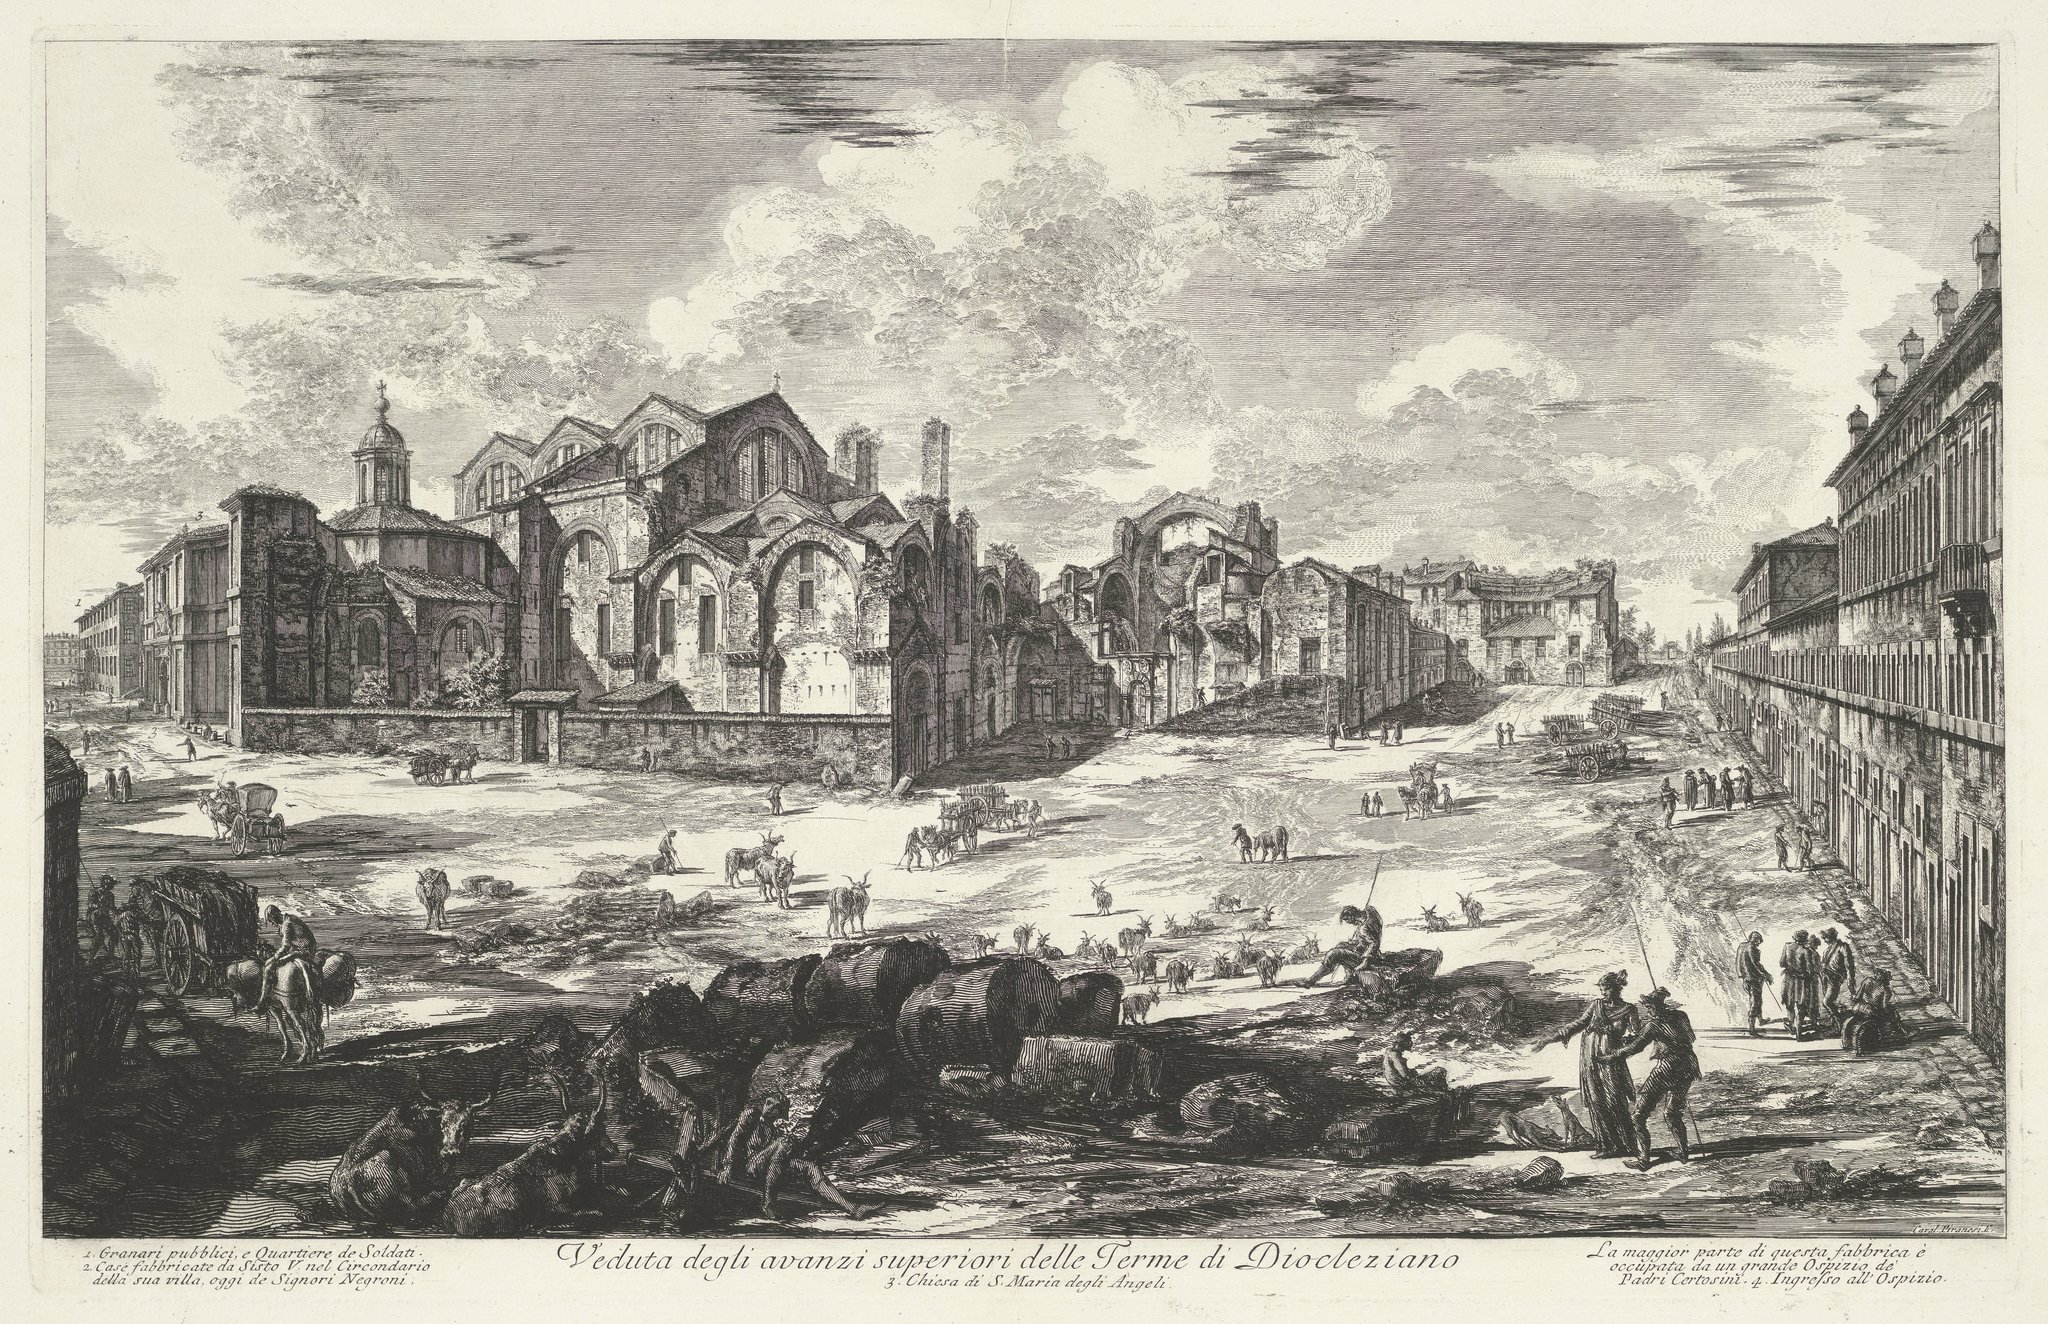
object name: print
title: Vedute di Roma disegnate ed incise da Giambattista Piranesi architetto Ve(nez)iano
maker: giovanni battista piranesi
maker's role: designer, draughtsman, print maker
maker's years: 1720-1778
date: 1748-1778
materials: paper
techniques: etching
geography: rome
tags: ruin of a building ~ architecture, landscape with ruins, public baths, roman catholic church, rome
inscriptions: collector's mark: Lugt 2228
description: Deze prent maakt deel uit van de serie 'Vedute di Roma'. Piranesi werkte aan deze 135 platen tellende serie tussen 1748 en zijn dood in 1778. Francesco Piranesi voegde later nog twee prenten toe aan de reeks van zijn vader.